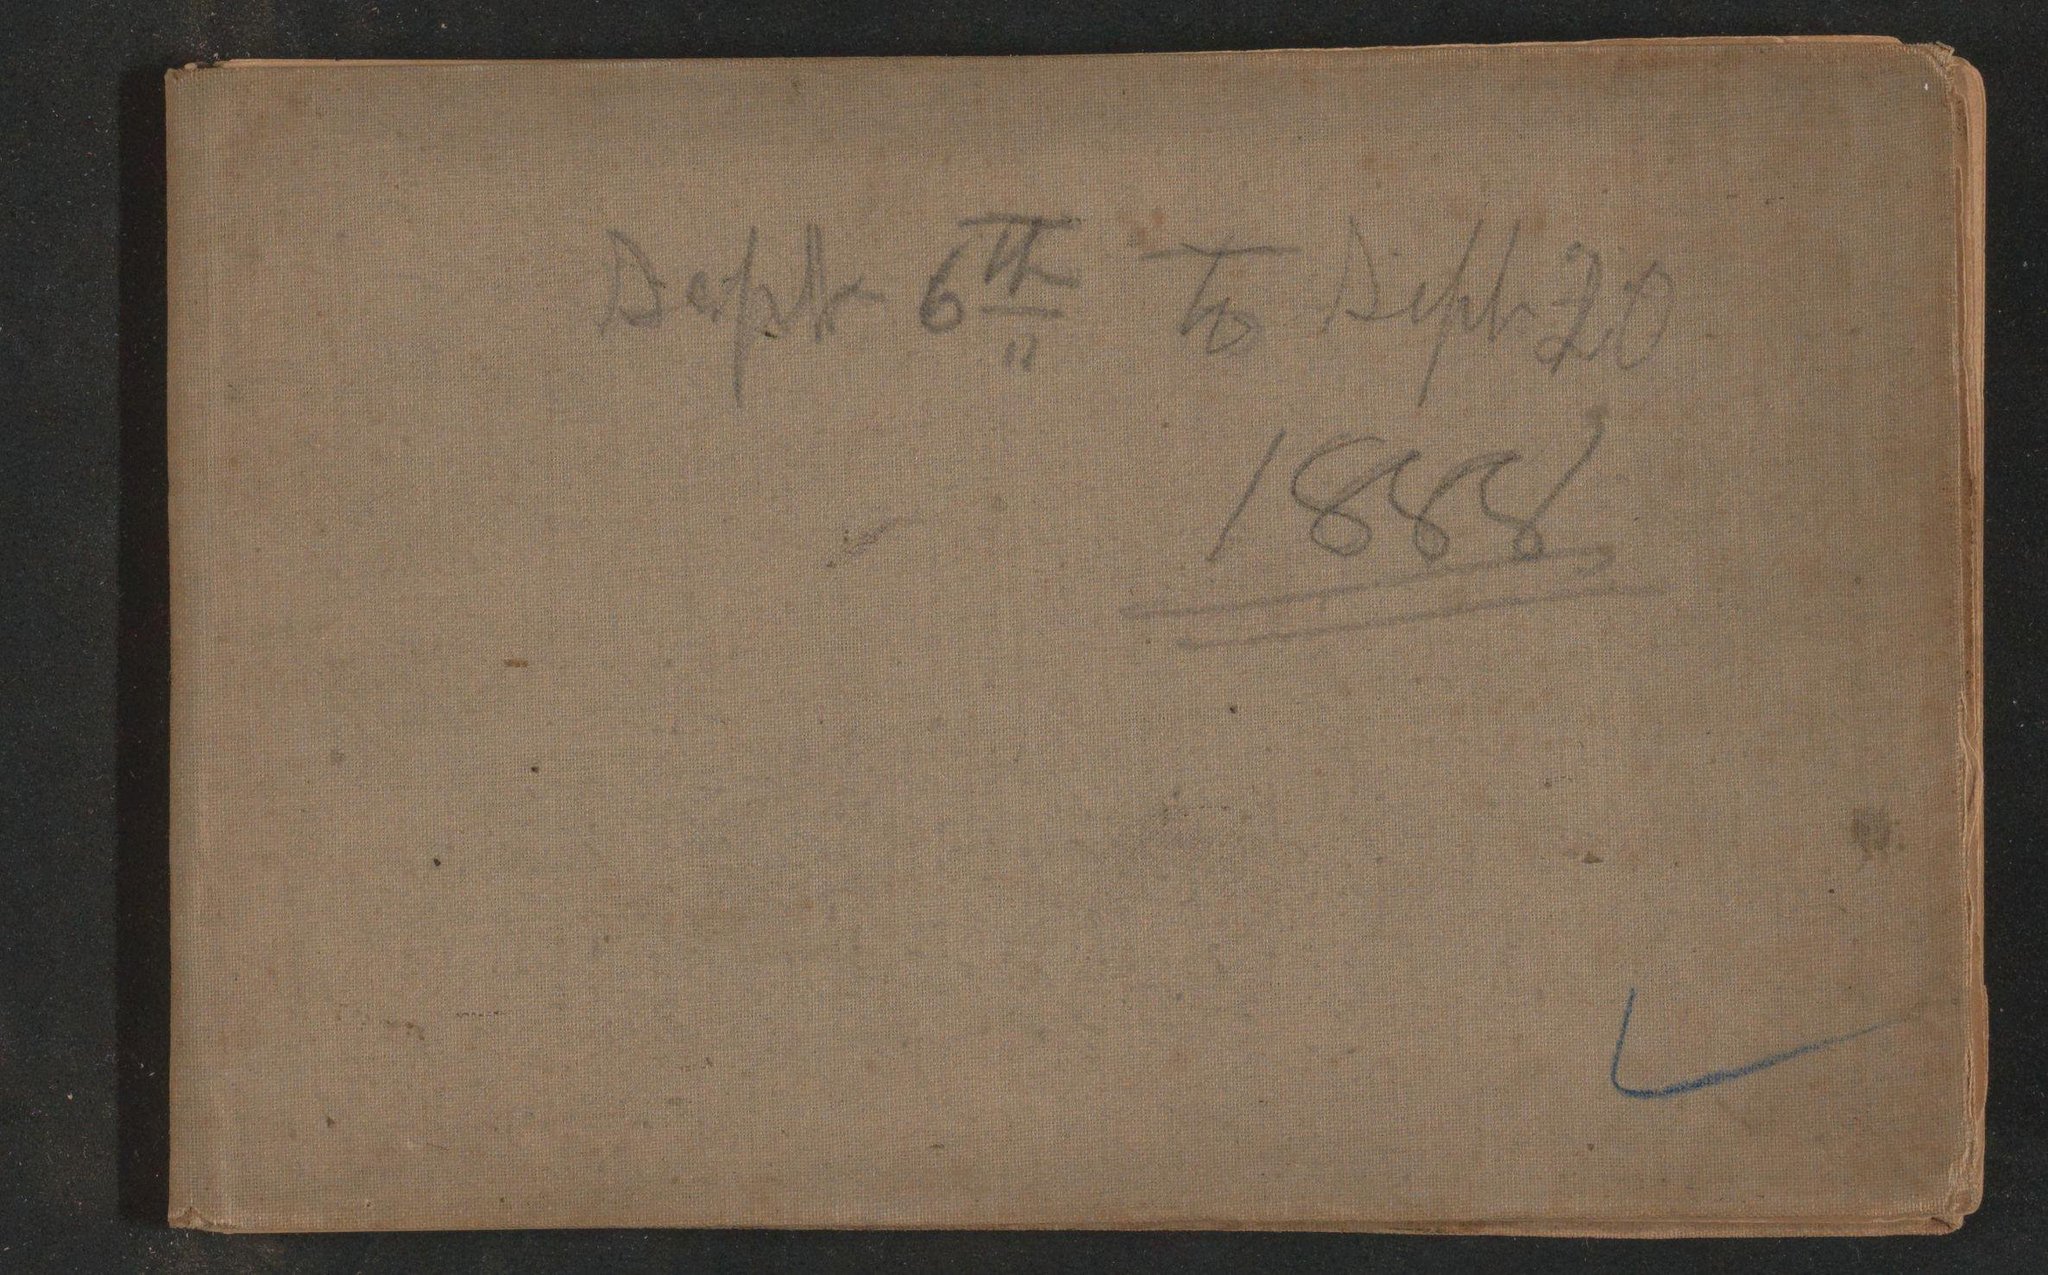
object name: sketchbook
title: Schetsboek met 34 bladen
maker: alexander shilling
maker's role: draughtsman, print maker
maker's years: 1859-1937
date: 1809-1888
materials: linen, paper, pencil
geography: south holland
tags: sailing-ship, sailing-boat, canals, waters (in city), windmill, street, delft, dordrecht, rotterdam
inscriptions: date and inscription: ‘Alexander Shilling/ Landschap schetsen uit Dordrecht, Rotter/ dam, Schiedam Delft, & den Haag.’, date: ‘sept 6th to sept 20/ 1888’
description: Schetsboek bestaande uit 34 bladen met landschappen en stadsgezichten gemaakt te Zuid-Holland in Schiedam, Delft, Den Haag, Dordrecht en Rotterdam. Op de achterzijde van de omslag potloodtekeningen, vermoedelijk van huizen.